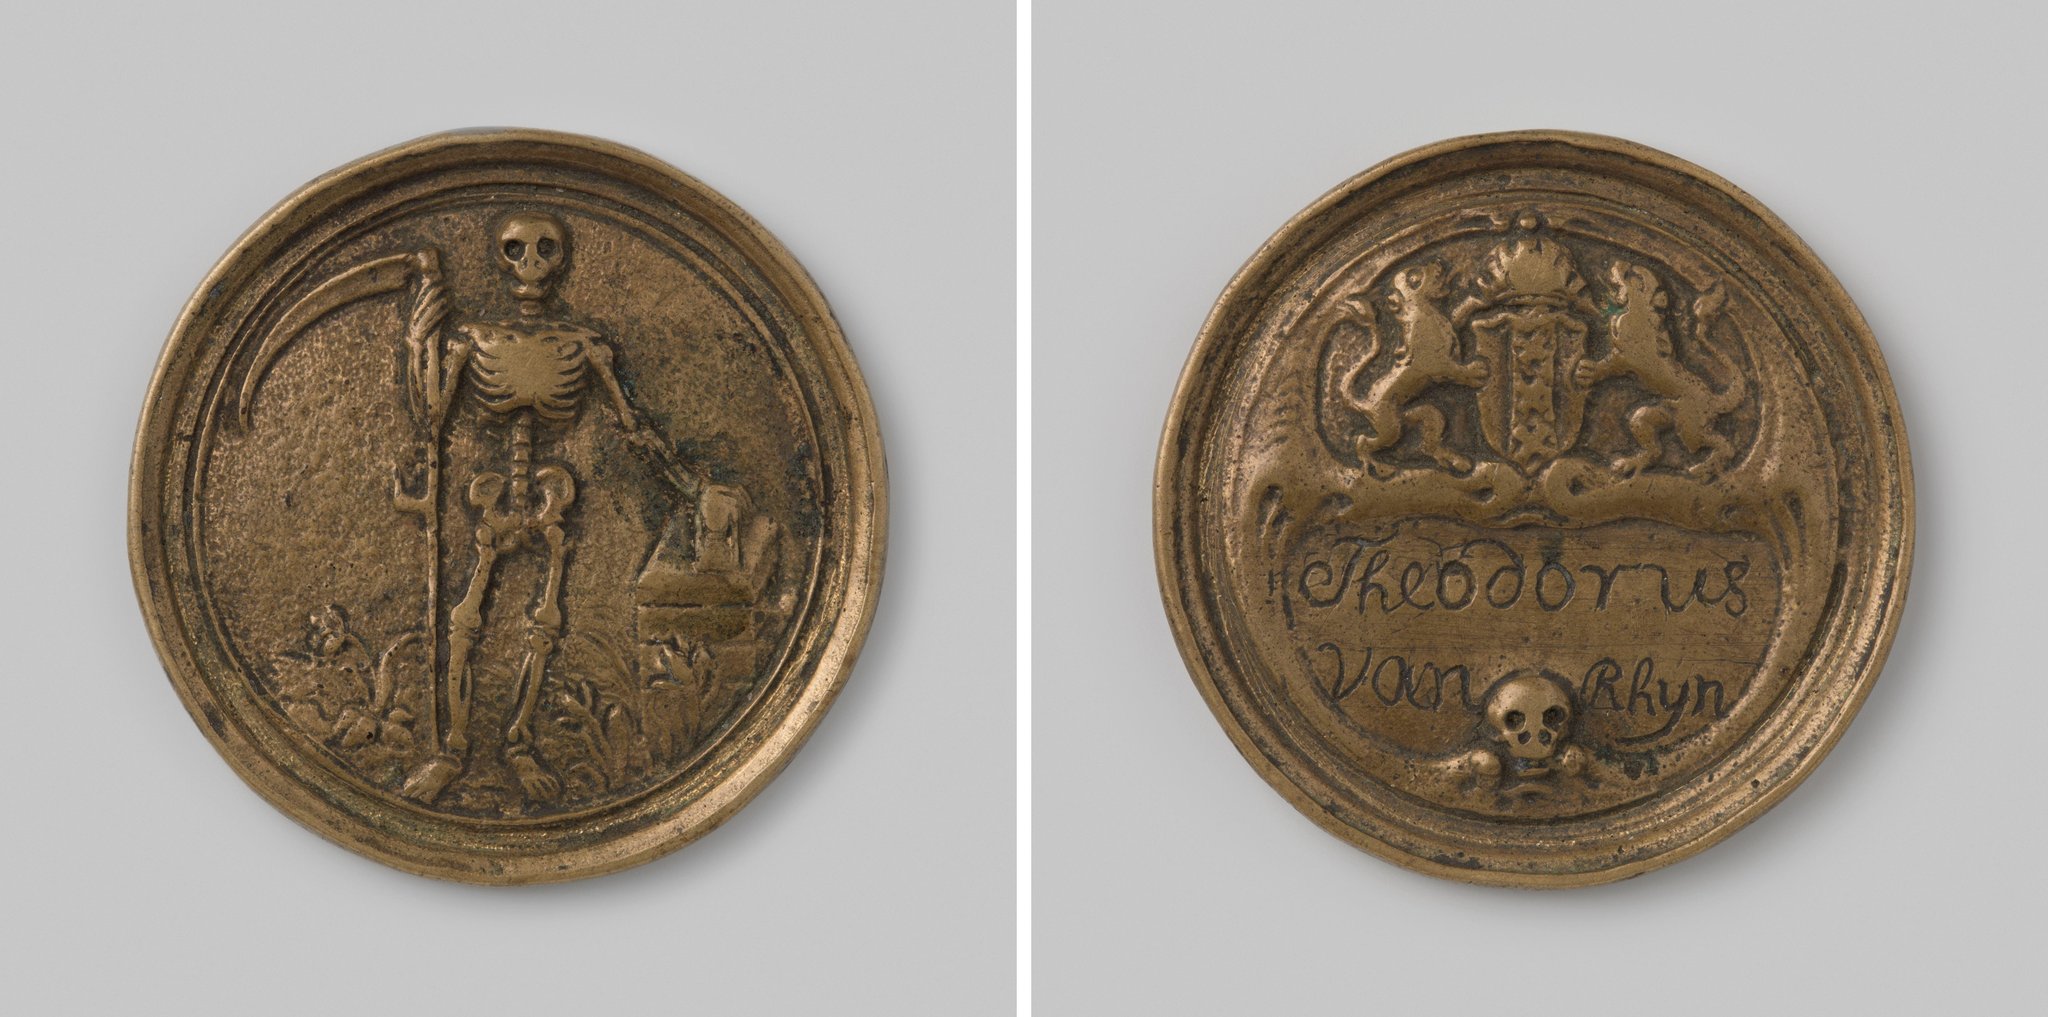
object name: medal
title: Presentiepenning van het Chirurgijnsgilde te Amsterdam, groot model 1654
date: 1654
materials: brass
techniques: casting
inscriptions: inscription: ‘Theodorus / van - Rhyn’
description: Gegoten messing penning, op de voorzijde de Dood met zeis en zandloper op altaar, op de keerzjde een gekroond wapenschild Amsterdam met dragers boven een inscriptieruimte en een doodshoofd, op naam van Theodorus van Rhyn